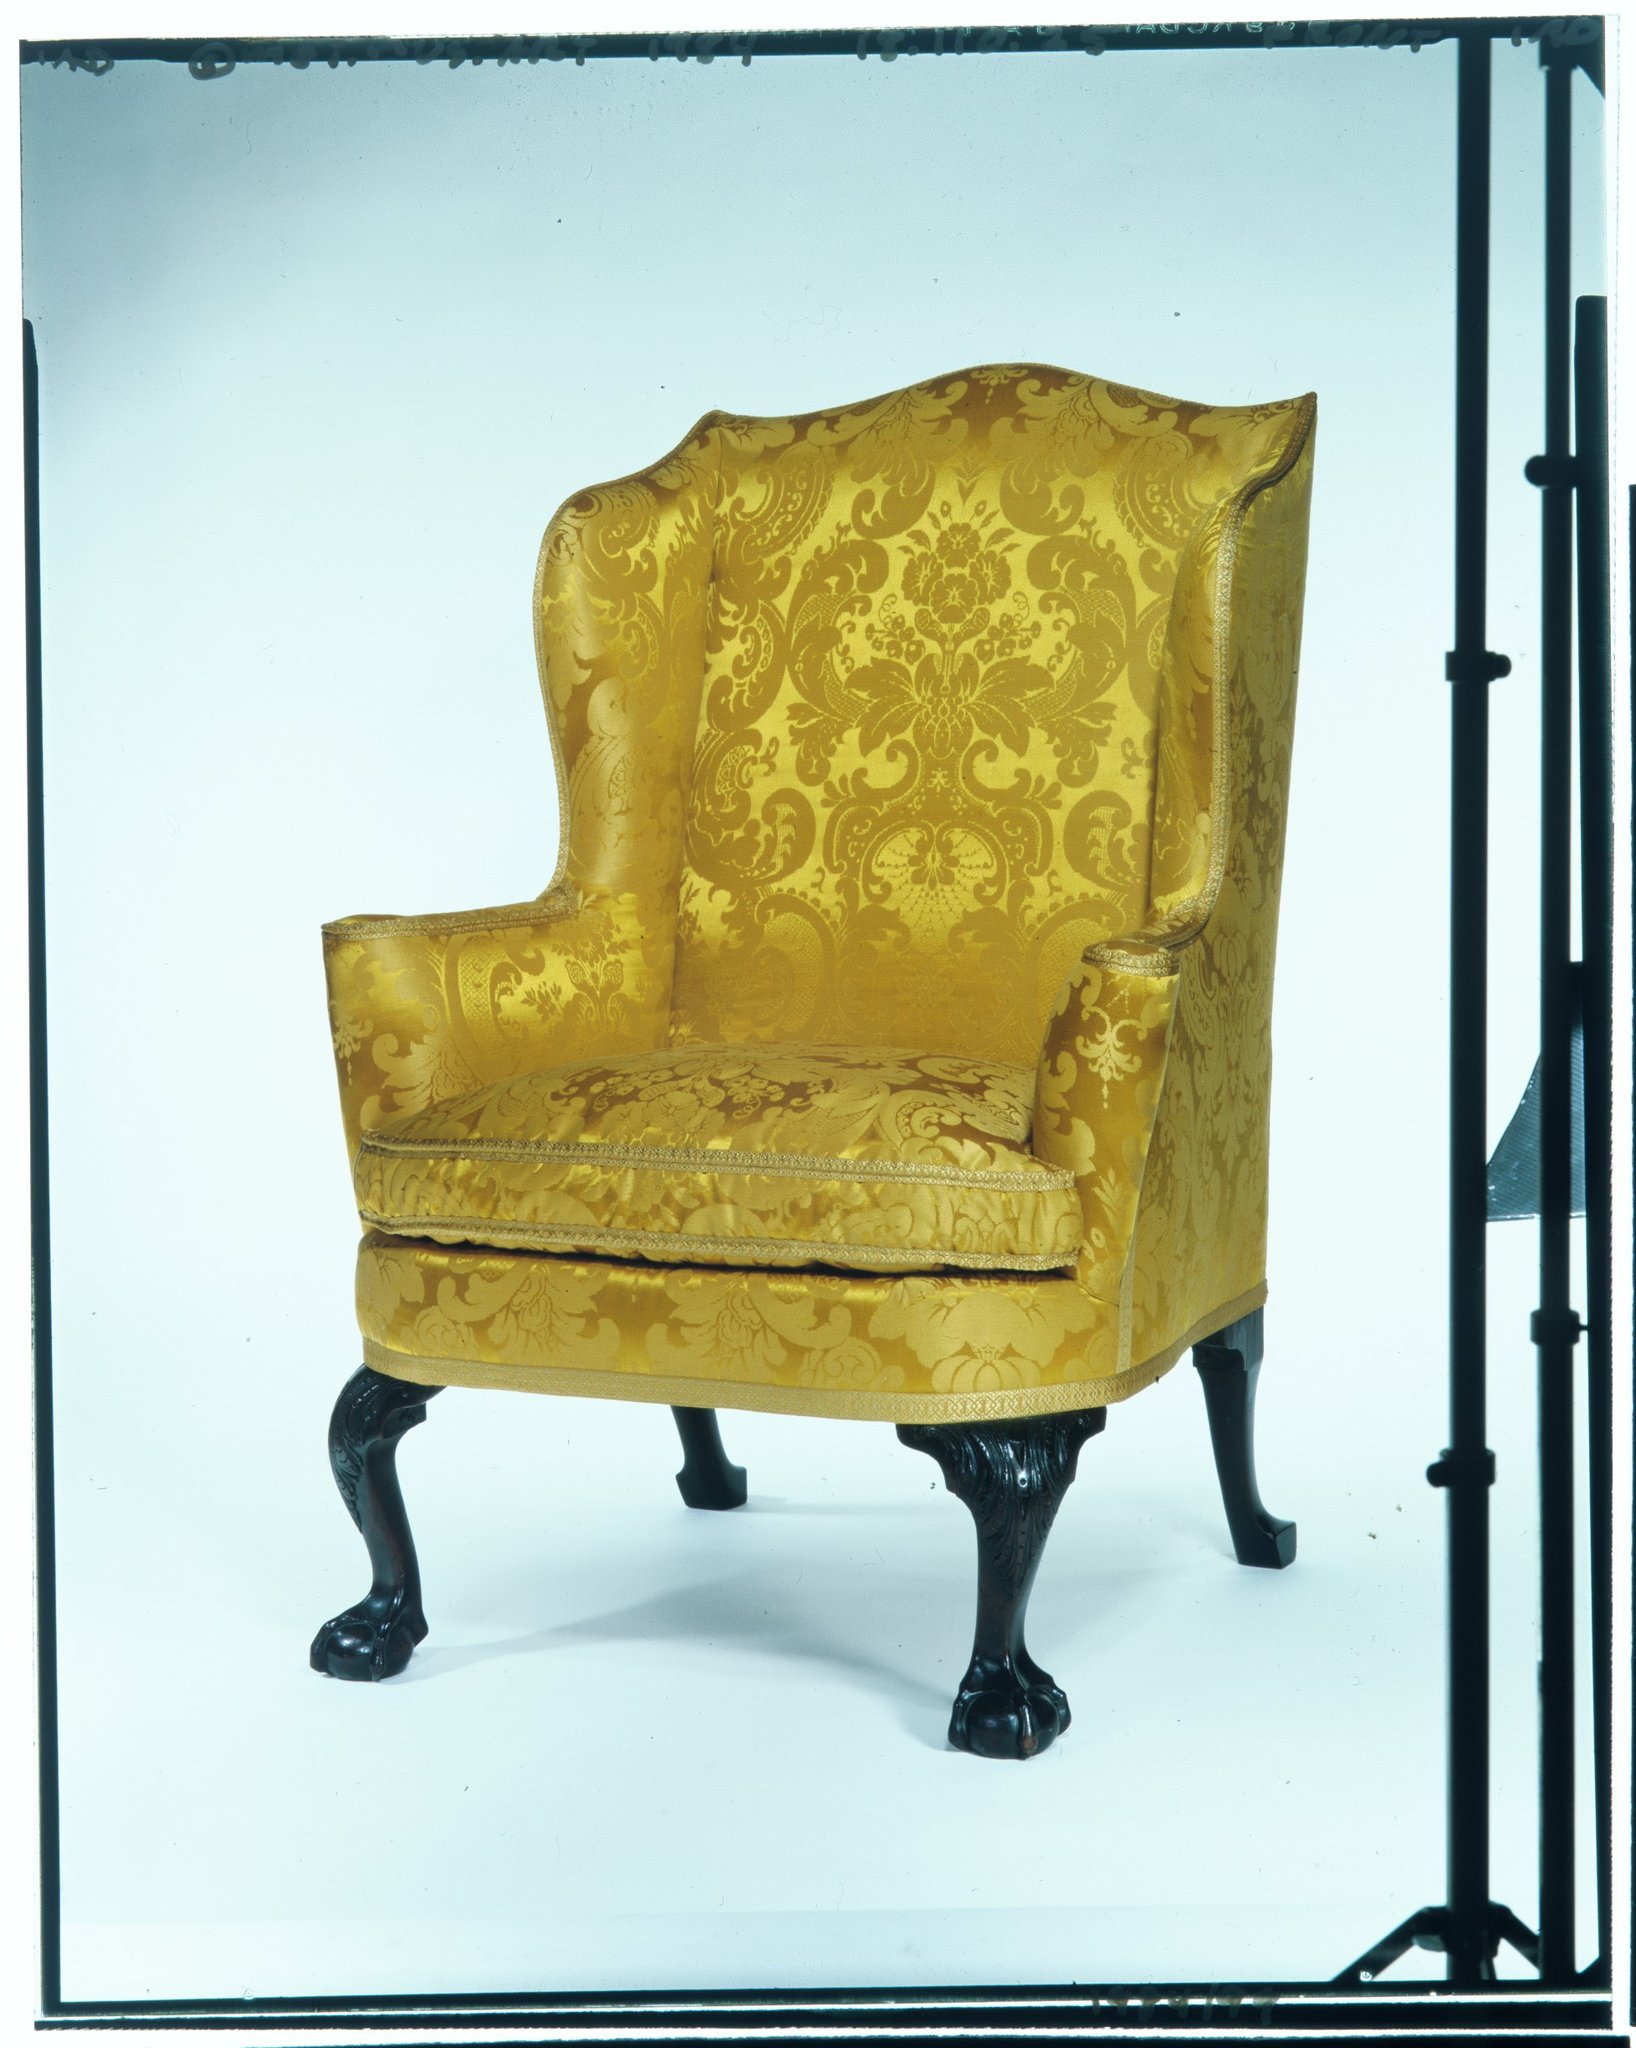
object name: easy chair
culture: american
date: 1760-1790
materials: wood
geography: united states